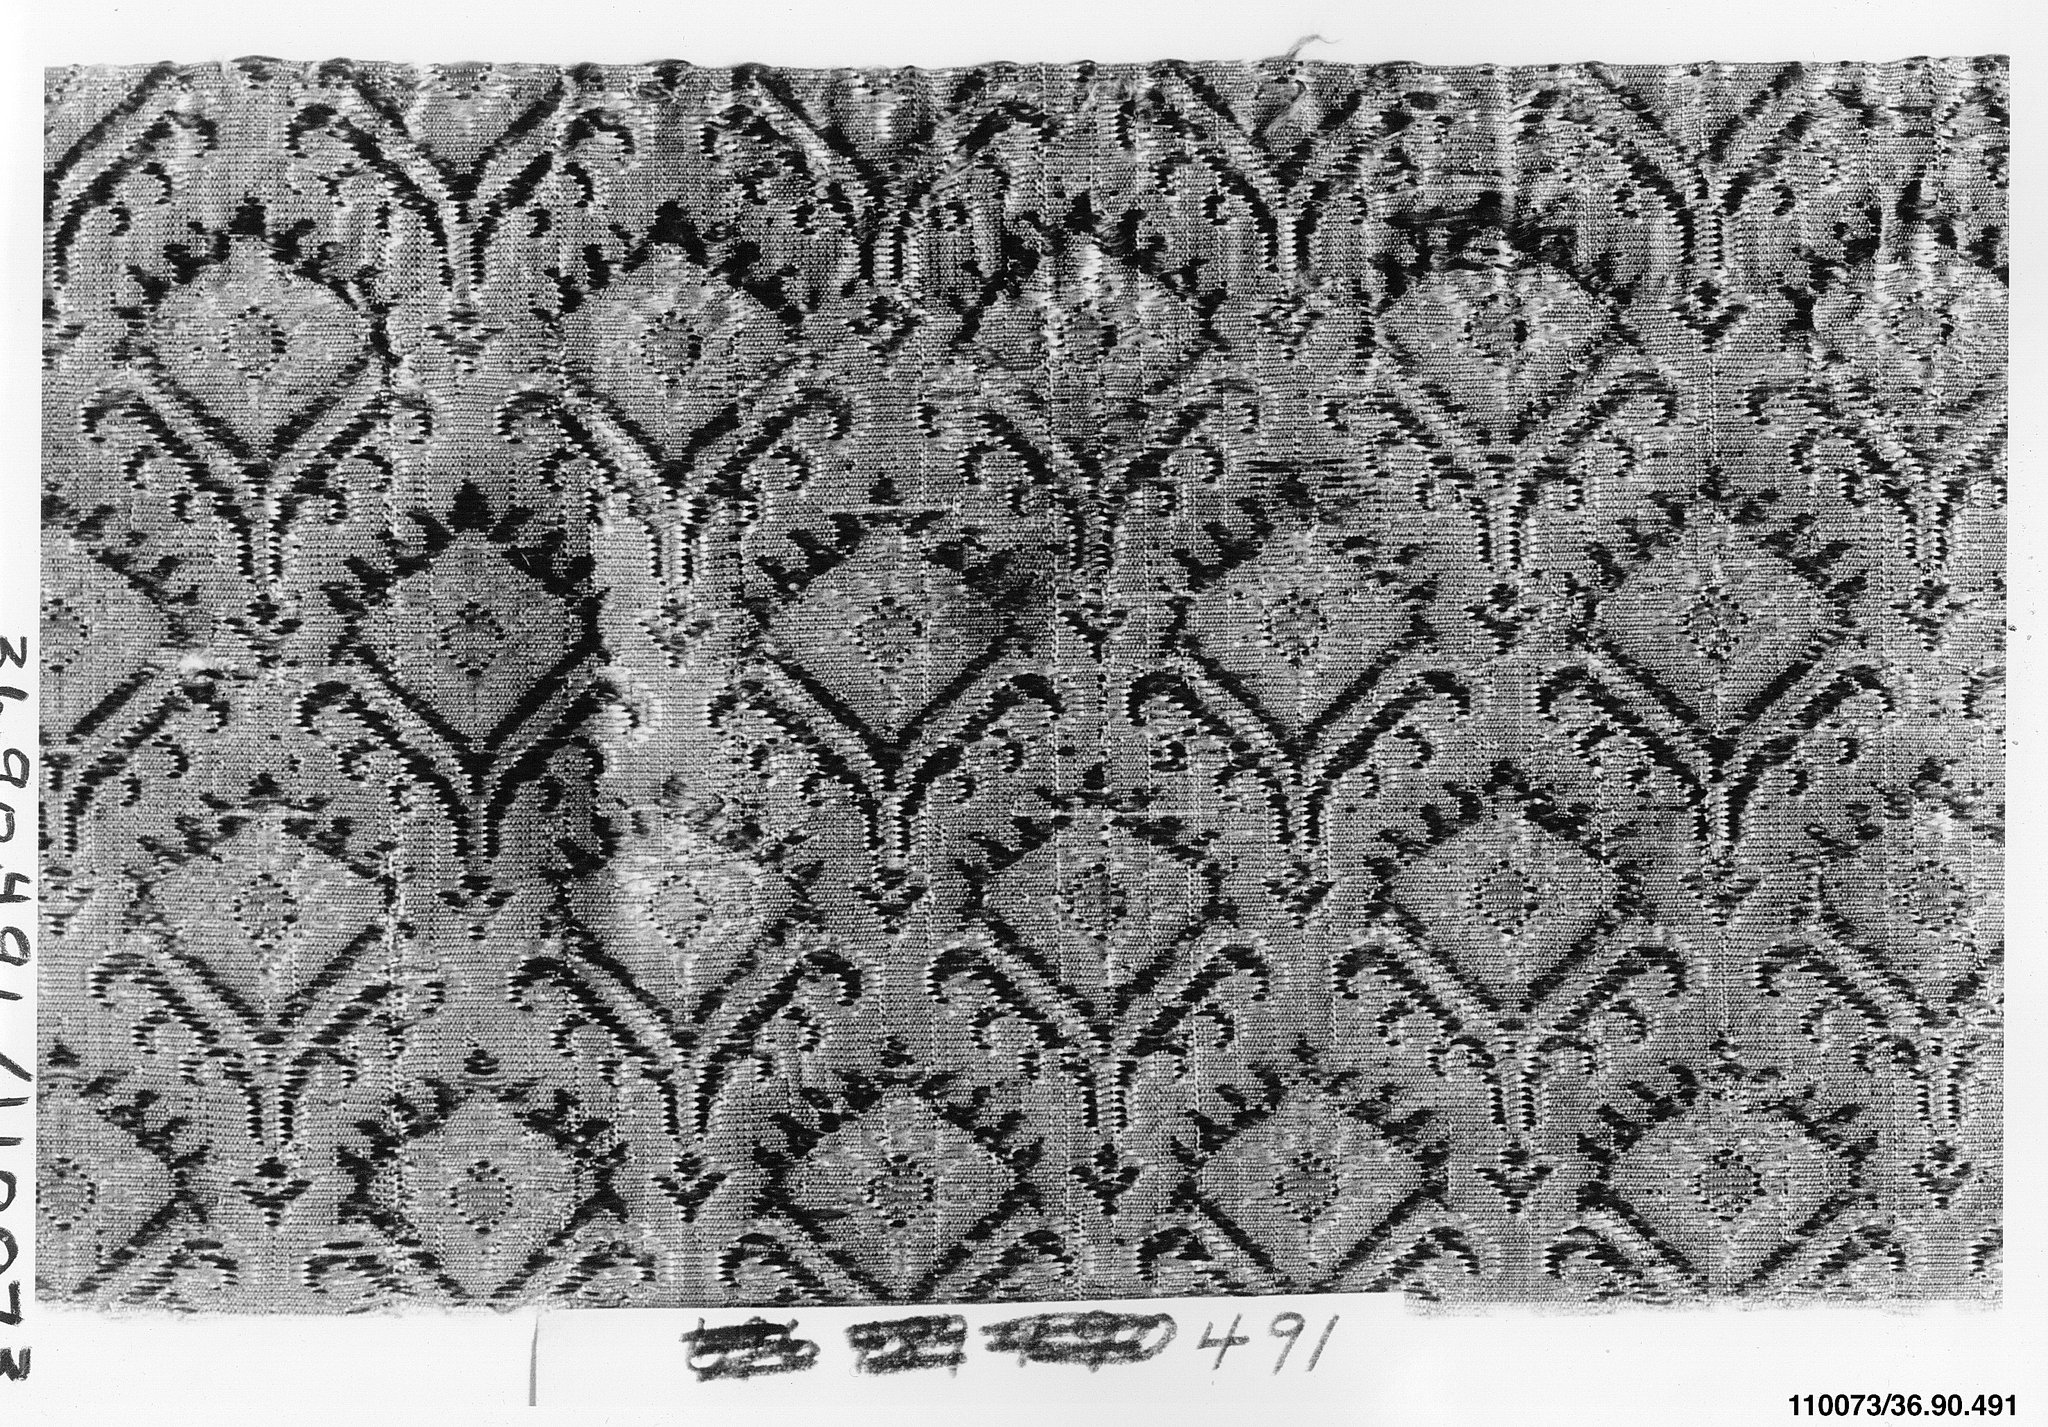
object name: piece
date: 1501-1700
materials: silk